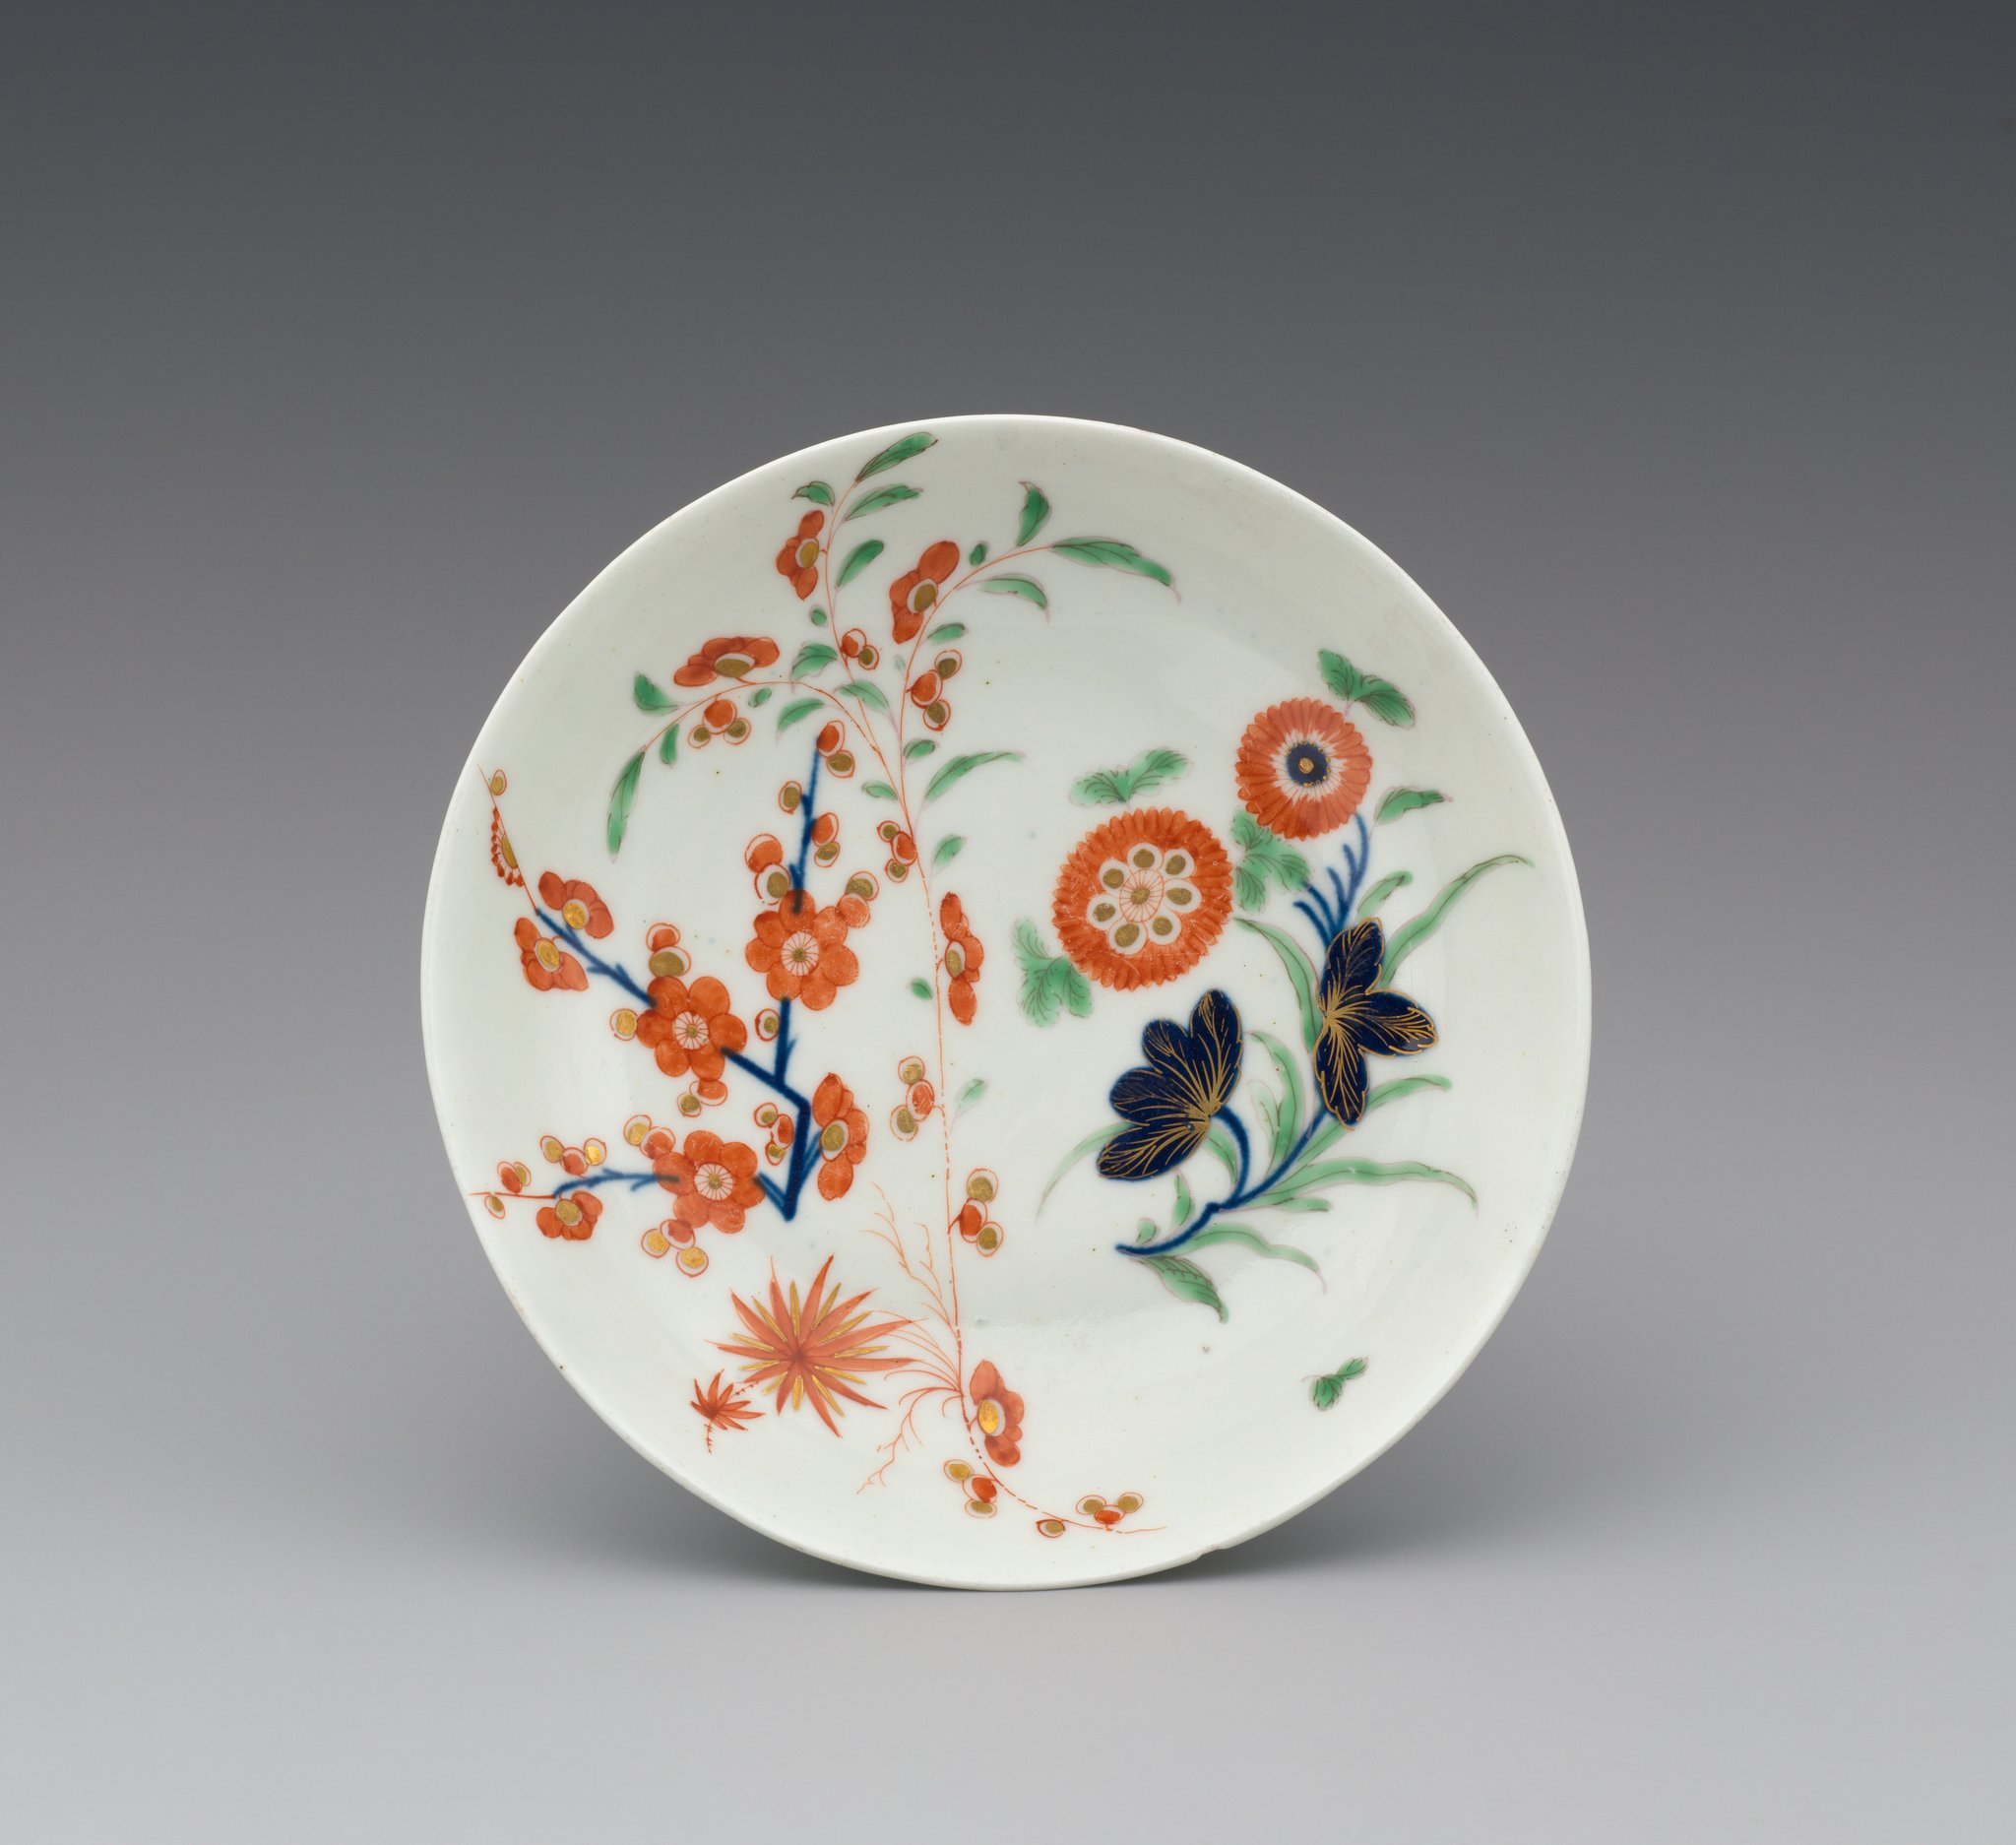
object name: saucer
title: Saucer (part of a service)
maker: worcester factory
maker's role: factory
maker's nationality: british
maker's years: 1751-2008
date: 1765-1770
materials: soft paste porcelain